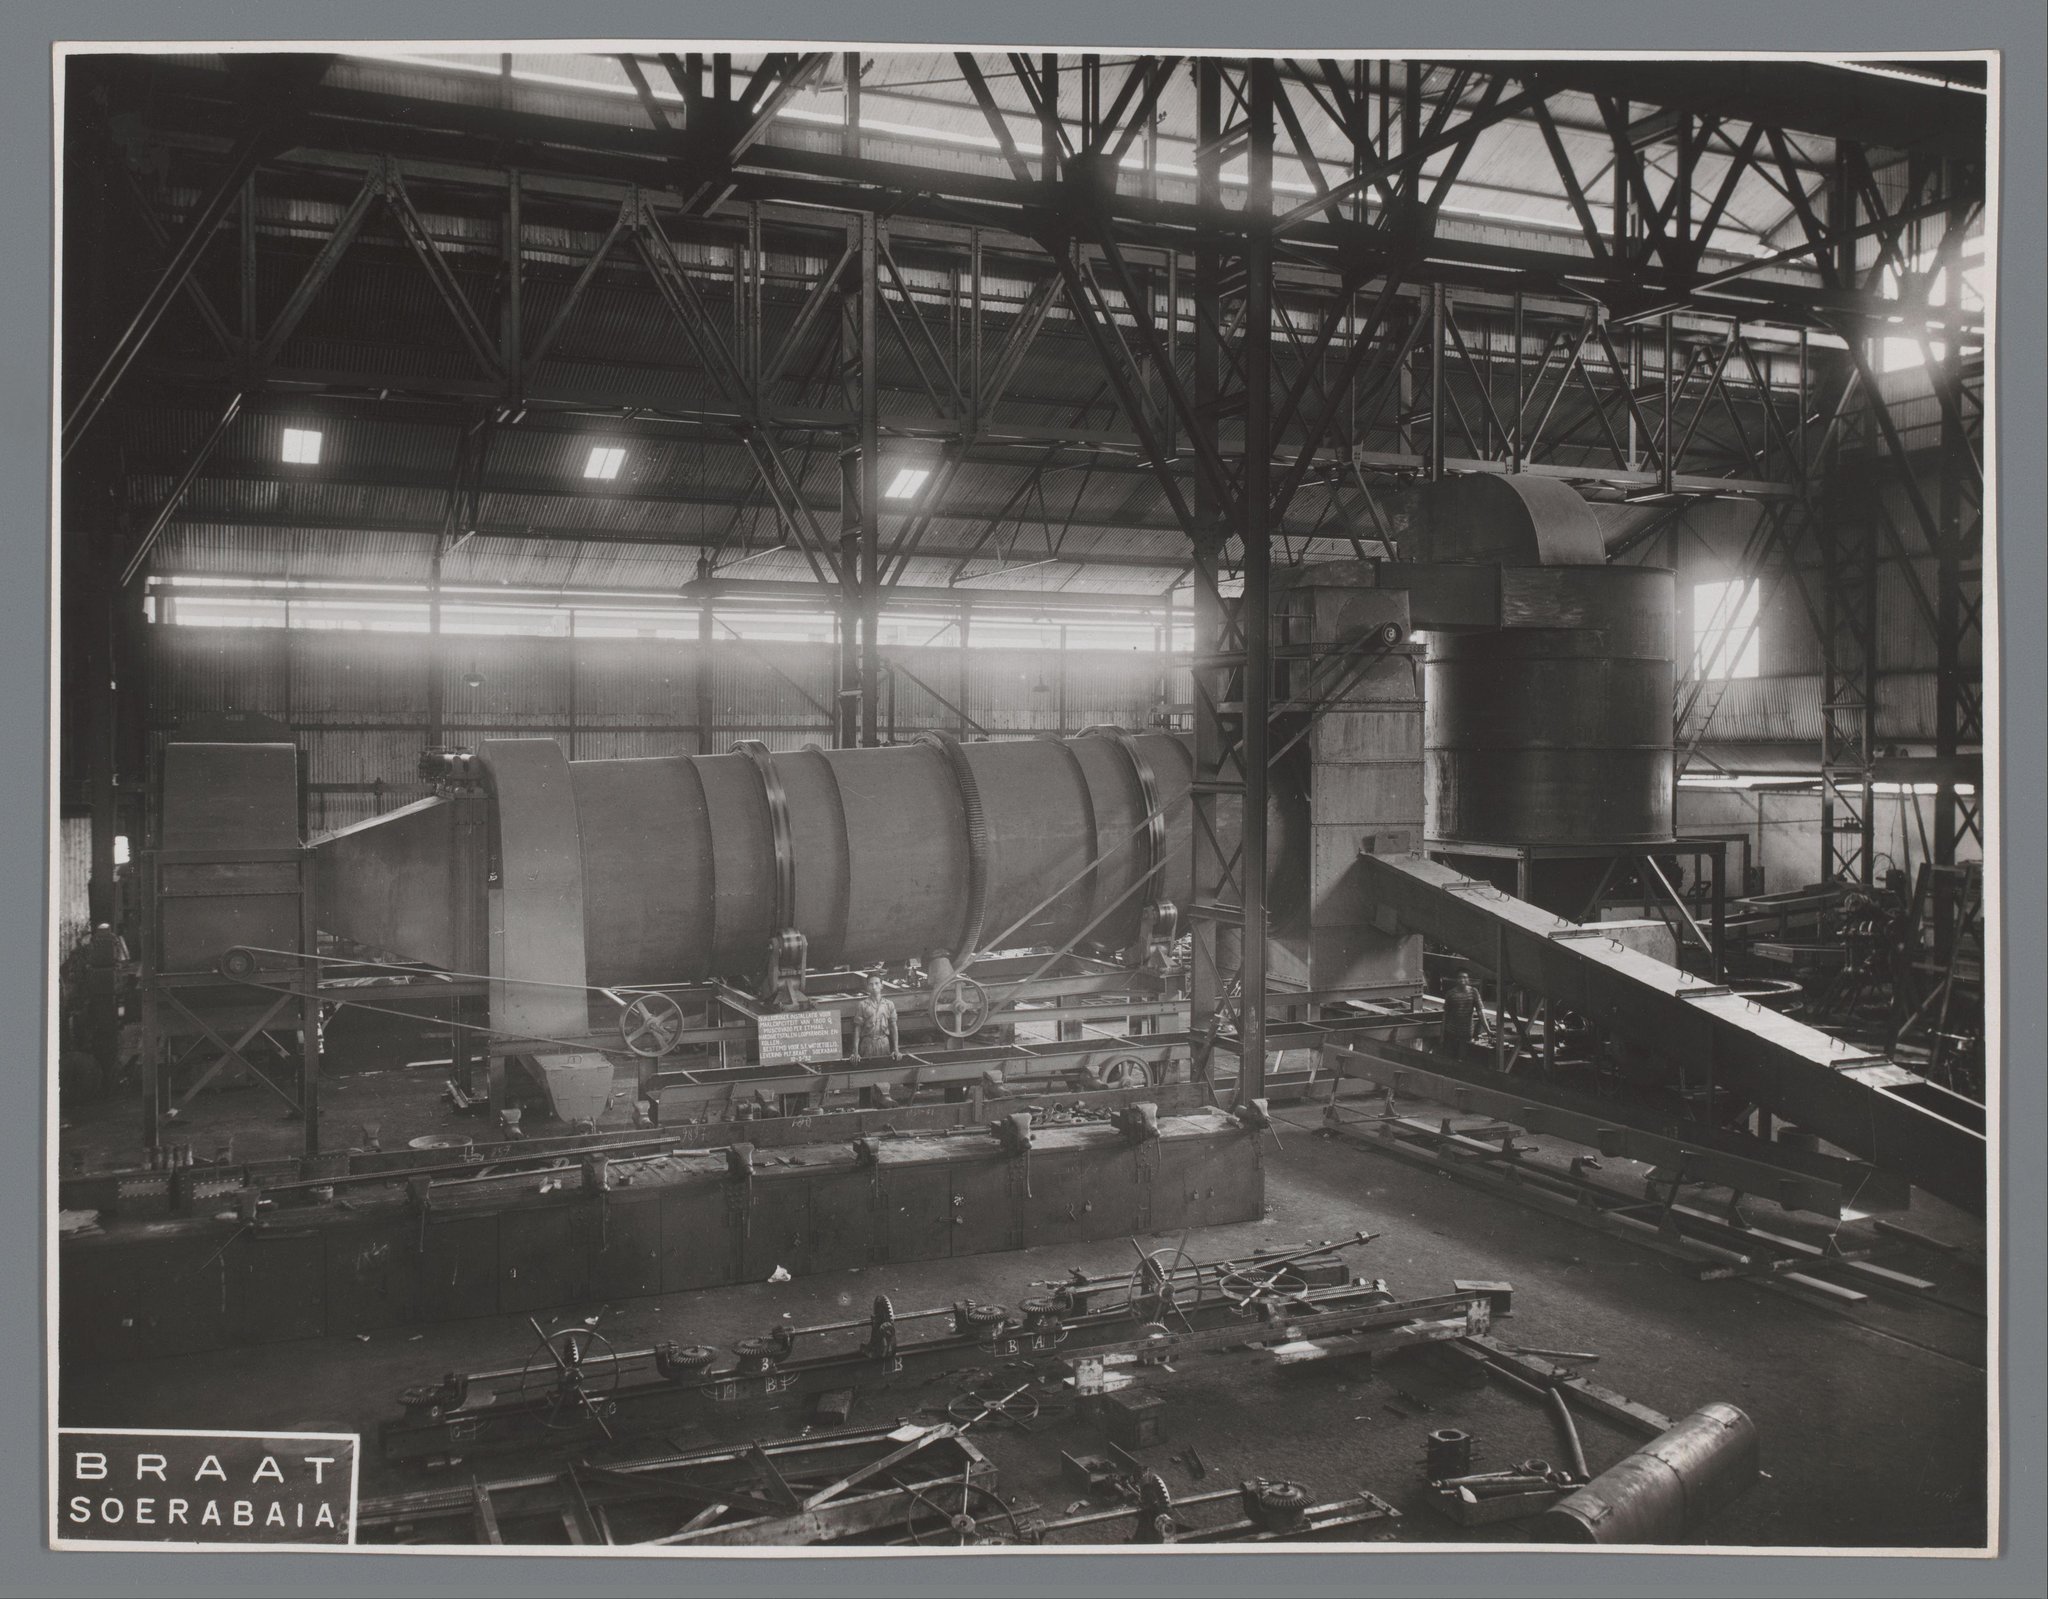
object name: photograph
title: Suikerdrooginstallatie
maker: Anonymous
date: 1932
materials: photographic support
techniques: gelatin silver print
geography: surabaya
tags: colonial system, factory-interior, machine shop, machines; parts of machines; tools and appliances, (non-fruit) products of plants or trees: sugarcane, java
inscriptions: date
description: Suikerdroger vervaardigd in 1932 voor de Suikerfabriek Watoetoelis bij Krijan ten westen van Sidoardjo. Onderdeel van de multomap met foto's van machines van de N.V. Machinefabriek Braat te Soerabaja bestemd voor de Nederlandse suikerindustrie op Java, uit de periode 1917-1938.